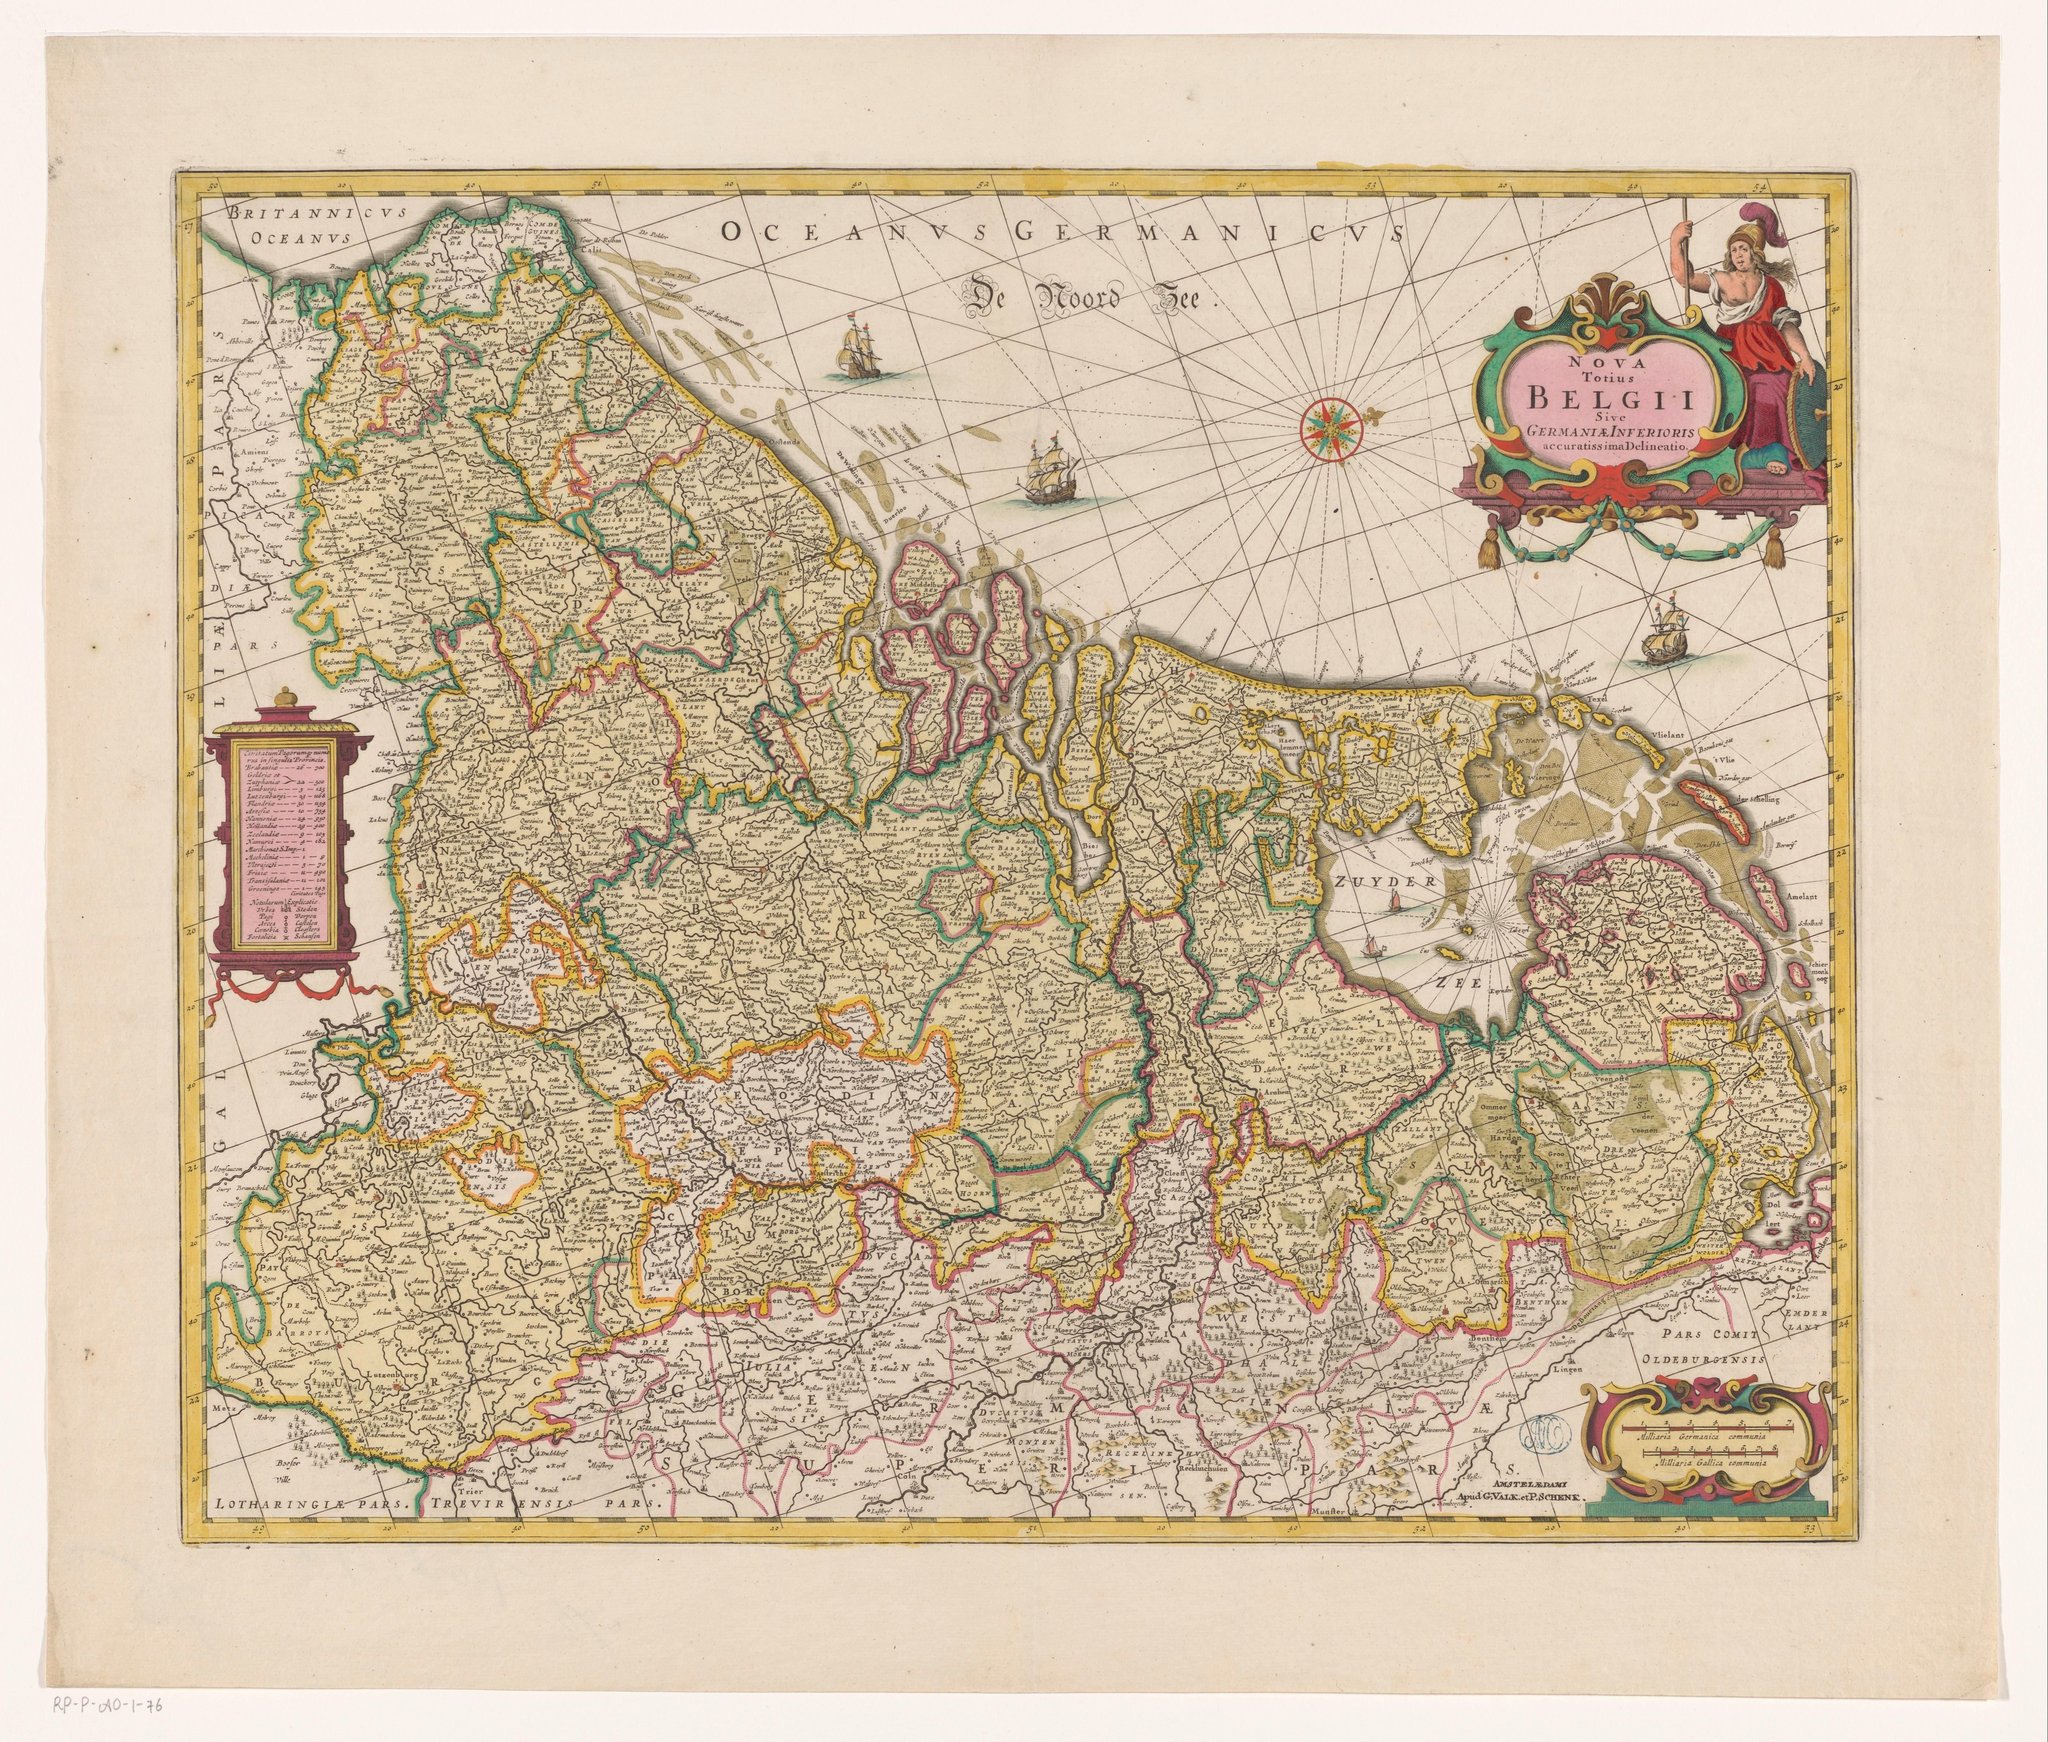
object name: map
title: Nova totius Belgii sive Germaniae Inferioris accuratissima delineatio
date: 1638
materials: paper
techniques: engraving, hand coloring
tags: maps of separate countries or regions, (story of) minerva (pallas, athena), low countries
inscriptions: collector's mark: Lugt 195, collector's mark: Lugt 2228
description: Links een cartouche met een overzicht van de provincies, topografische informatie en een legenda. Rechtsboven titelcartouche, links daarvan staat Minerva afgebeeld. Rechtsonder schaalstok: Milliaria Germanica communia, Milliaria Gallica communia. Gradenverdeling langs de randen. Oriëntatie: noorden rechts. Op verso Latijnse tekst in boekdruk, titel: Germania Inferior sive Belgica hodierna.